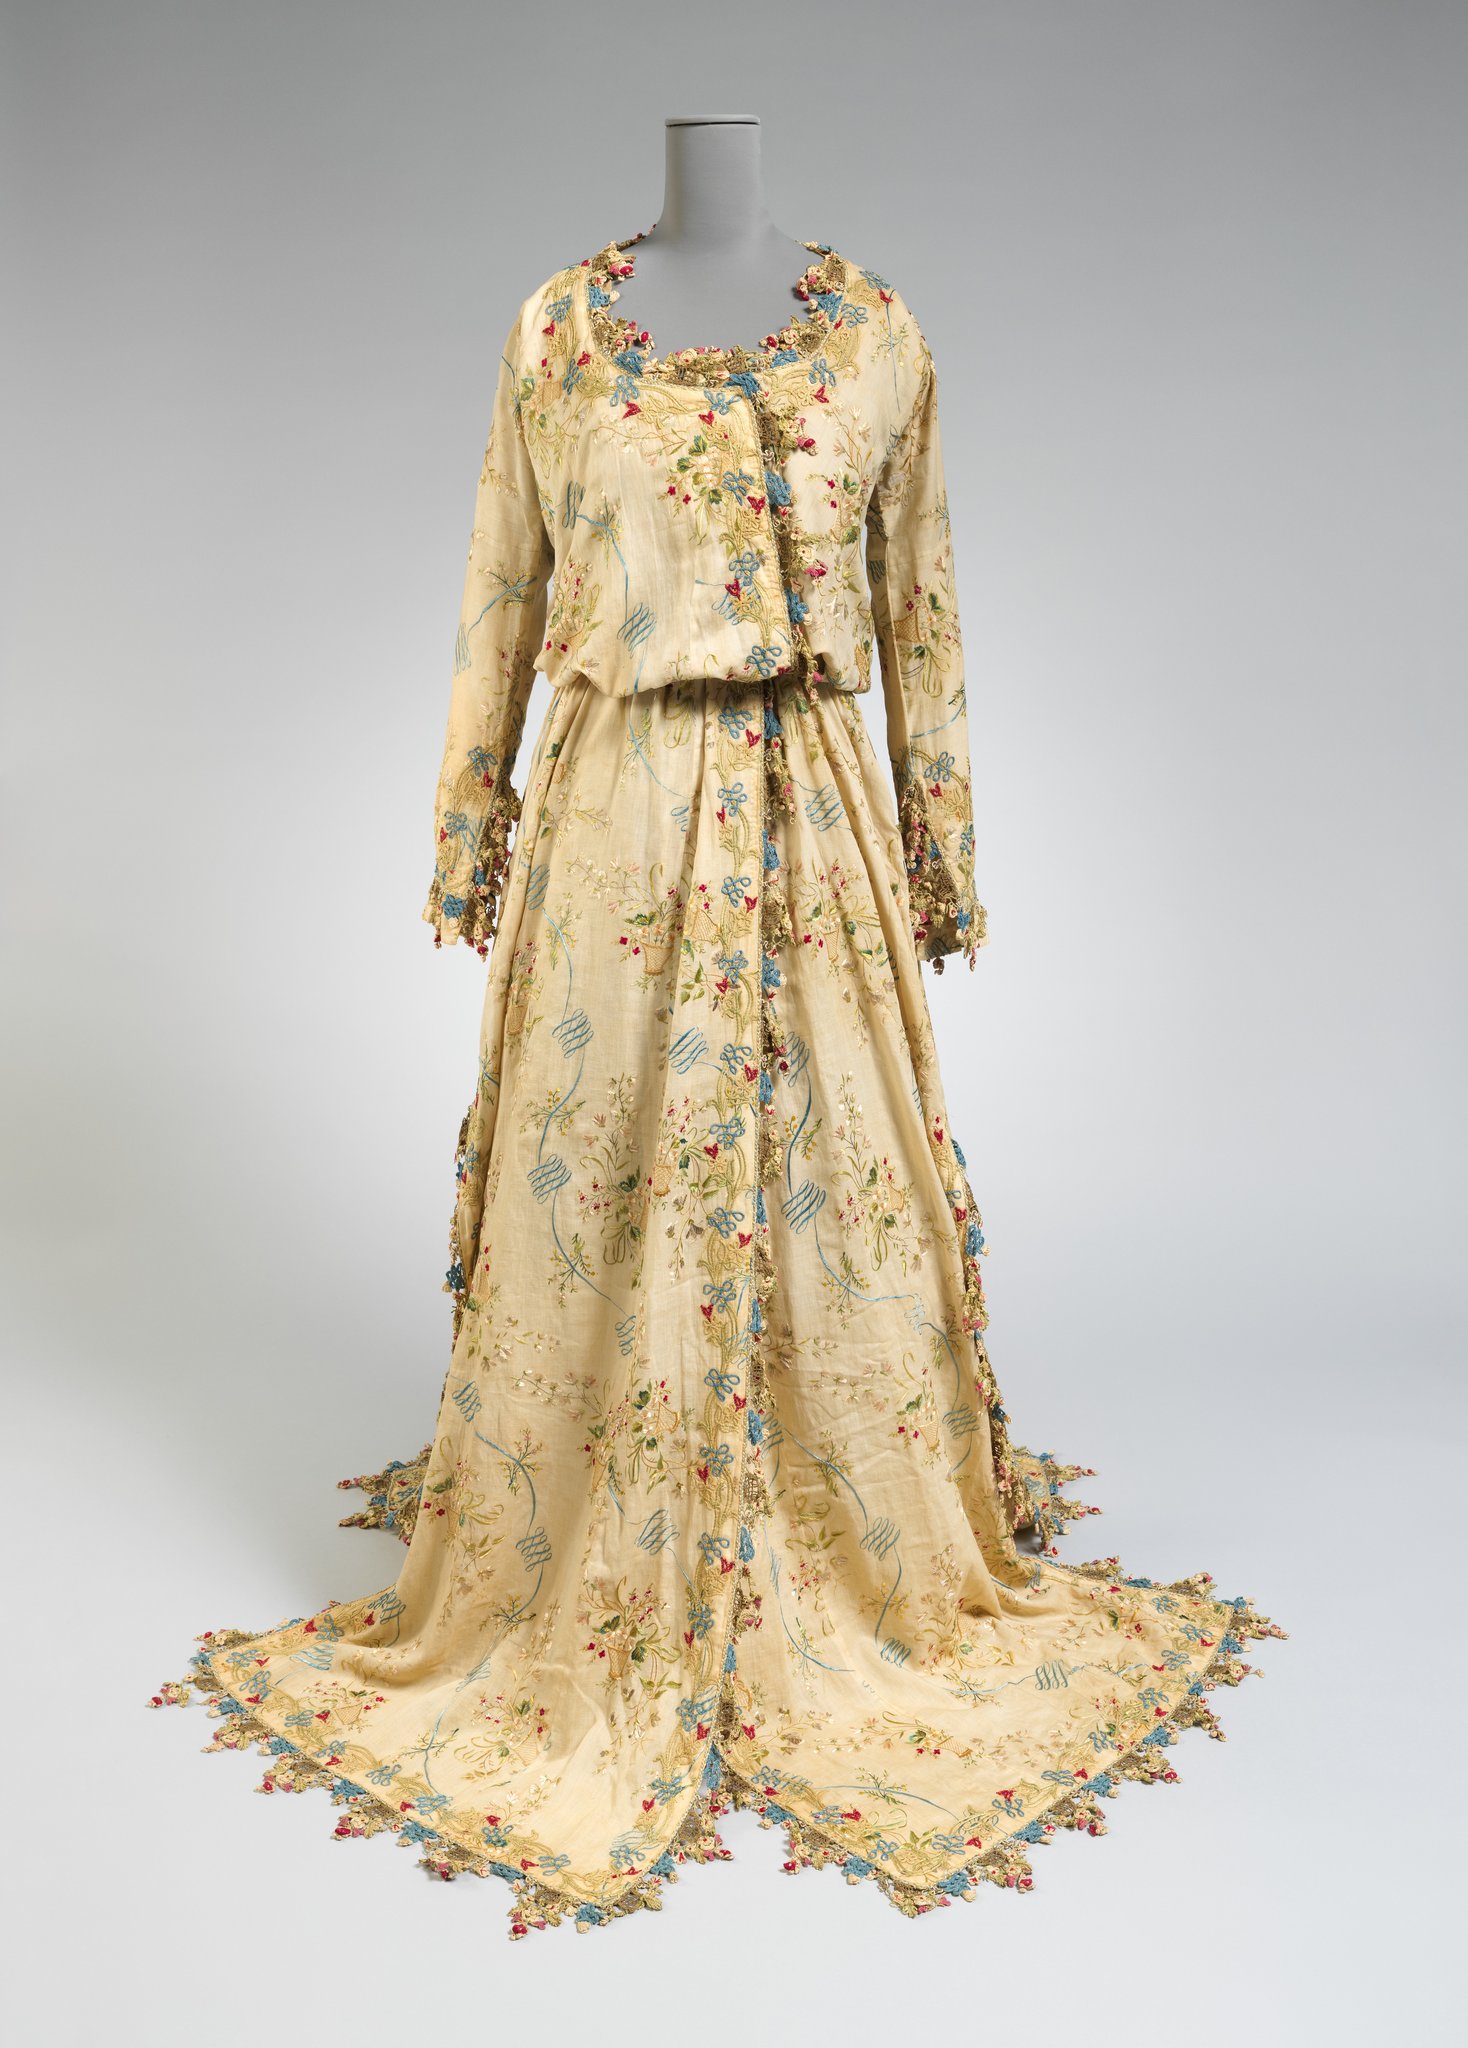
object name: robe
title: Uçetek Entari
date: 1801-1900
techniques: embroidery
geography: turkey